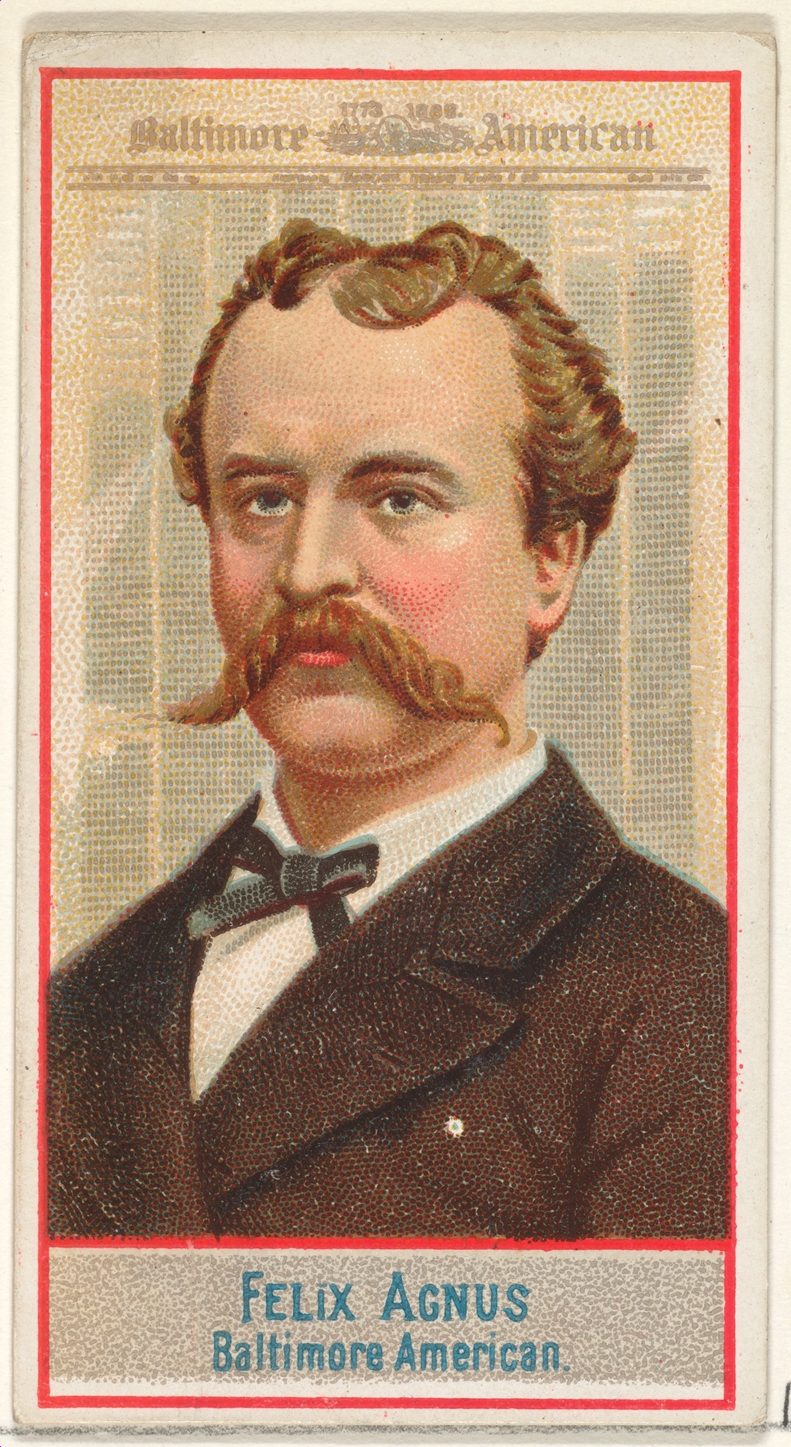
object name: print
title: Felix Agnus, Baltimore American, from the American Editors series (N1) for Allen & Ginter Cigarettes Brands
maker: allen & ginter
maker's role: publisher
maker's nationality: american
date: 1887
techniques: color lithograph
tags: men,portraits